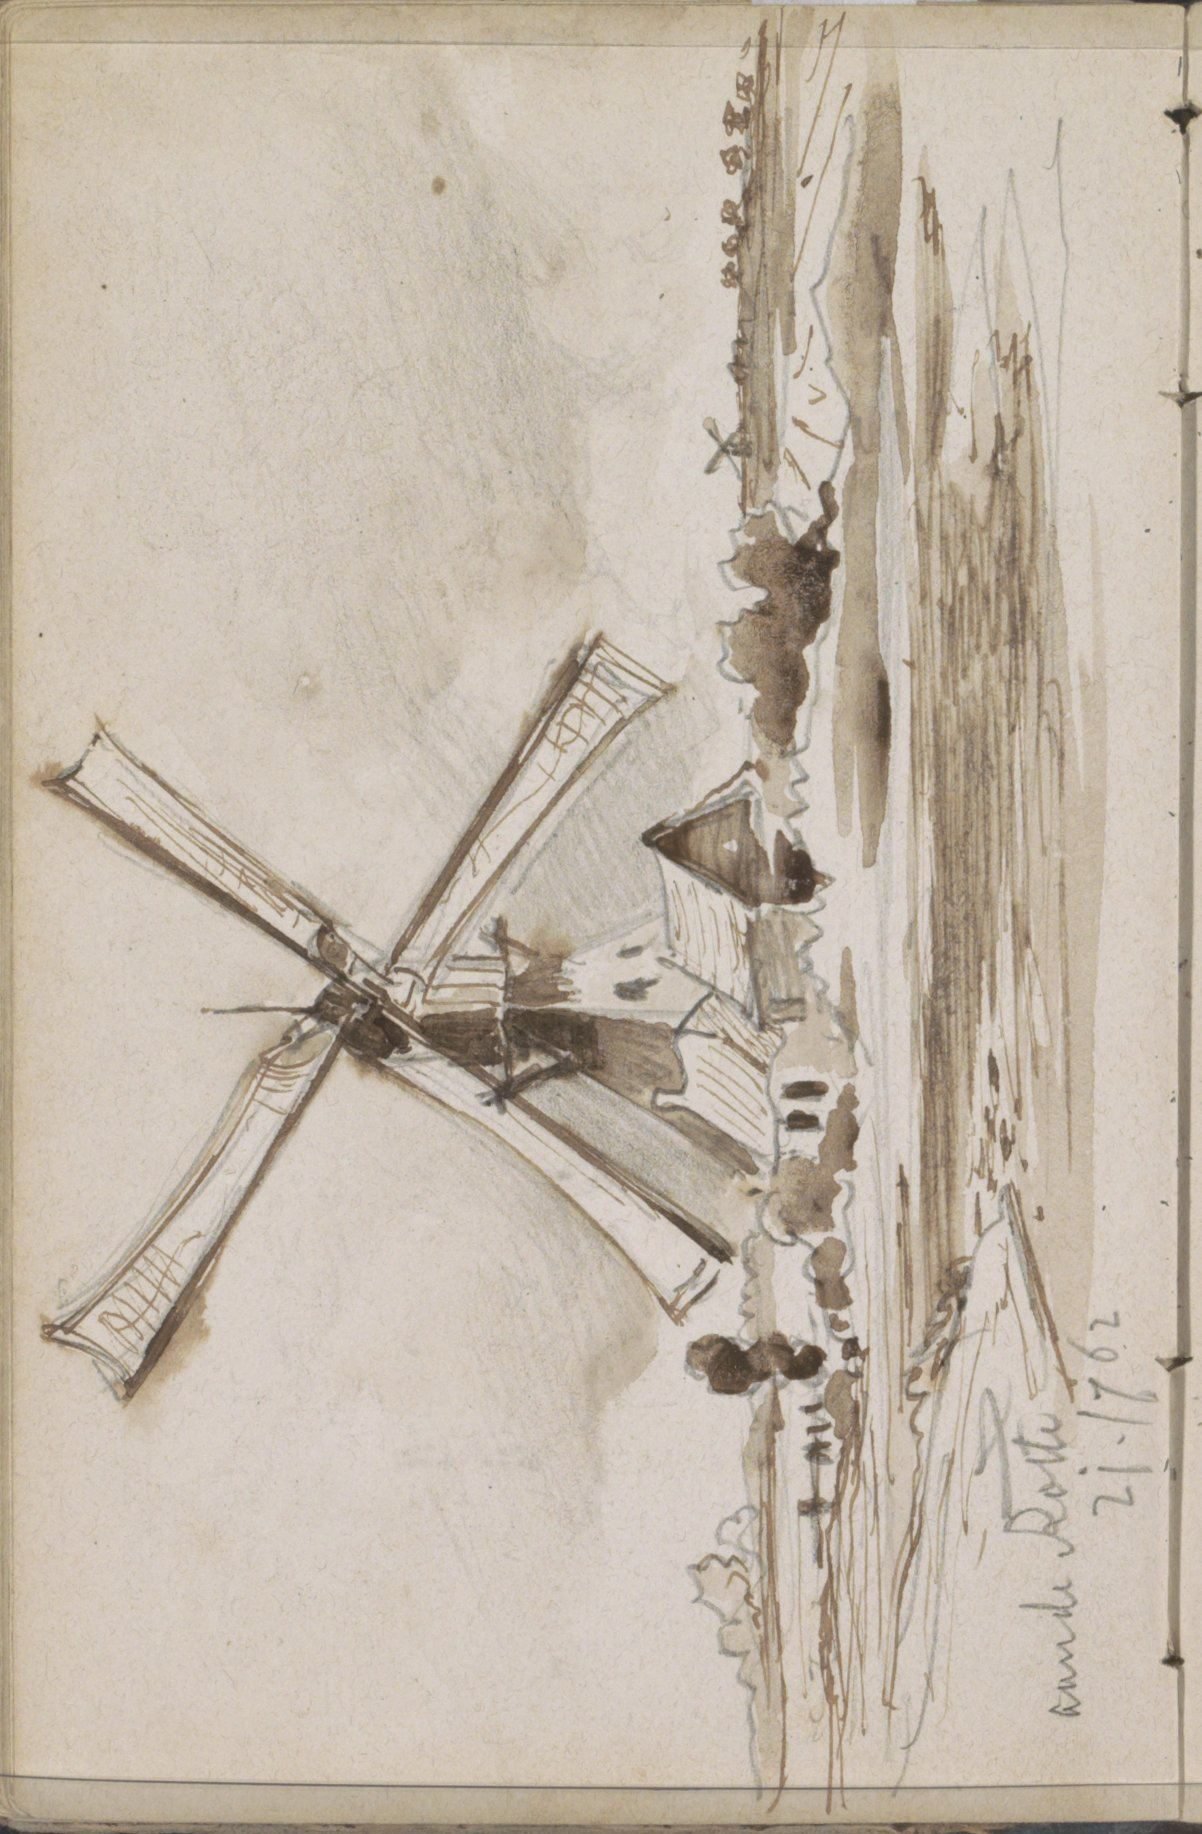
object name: sketchbook leaf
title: Molen aan de Rotte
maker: johannes tavenraat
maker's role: draughtsman, painter, print maker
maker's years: 1809-1881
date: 1807-1862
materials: ink, paper, pencil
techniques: brush, pen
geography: rotte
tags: windmill in landscape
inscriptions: date and inscription: ‘aan de Rotte/ 21/7 62’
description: Blad 22 verso uit een schetsboek met 65 bladen.